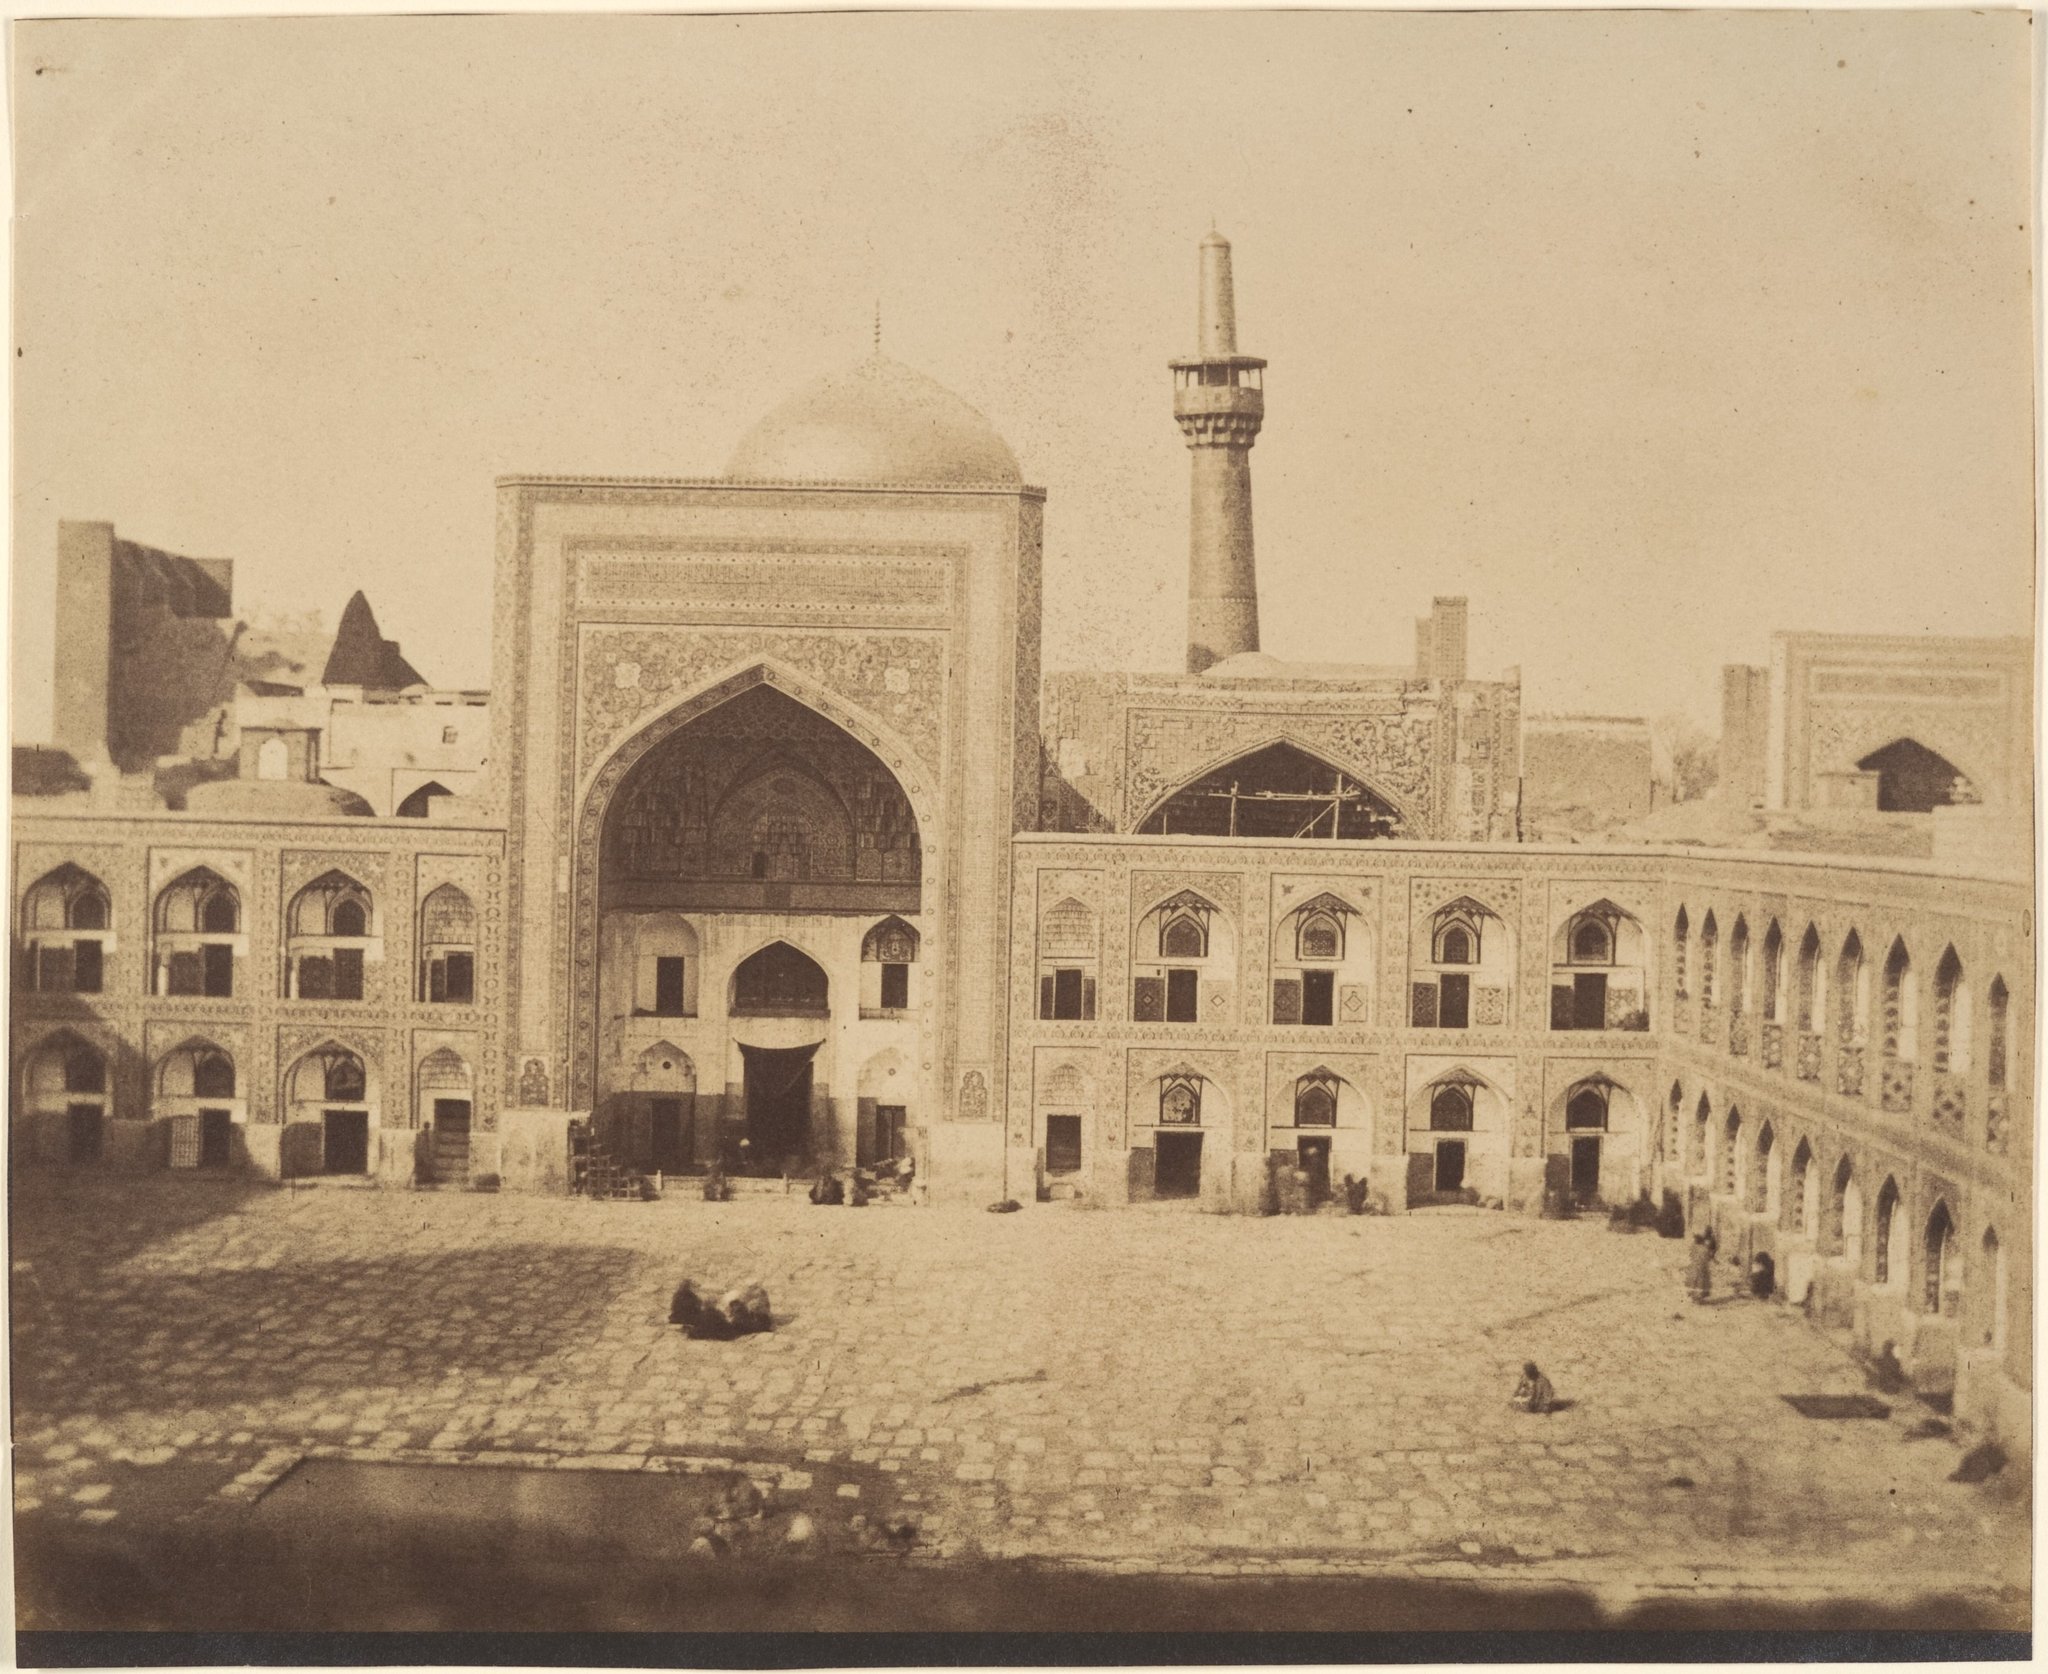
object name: photograph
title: [New Court of Imam Riza, MESHED]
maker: luigi pesce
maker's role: artist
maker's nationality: italian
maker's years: 1818-1891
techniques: albumen silver print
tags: architecture,mosques